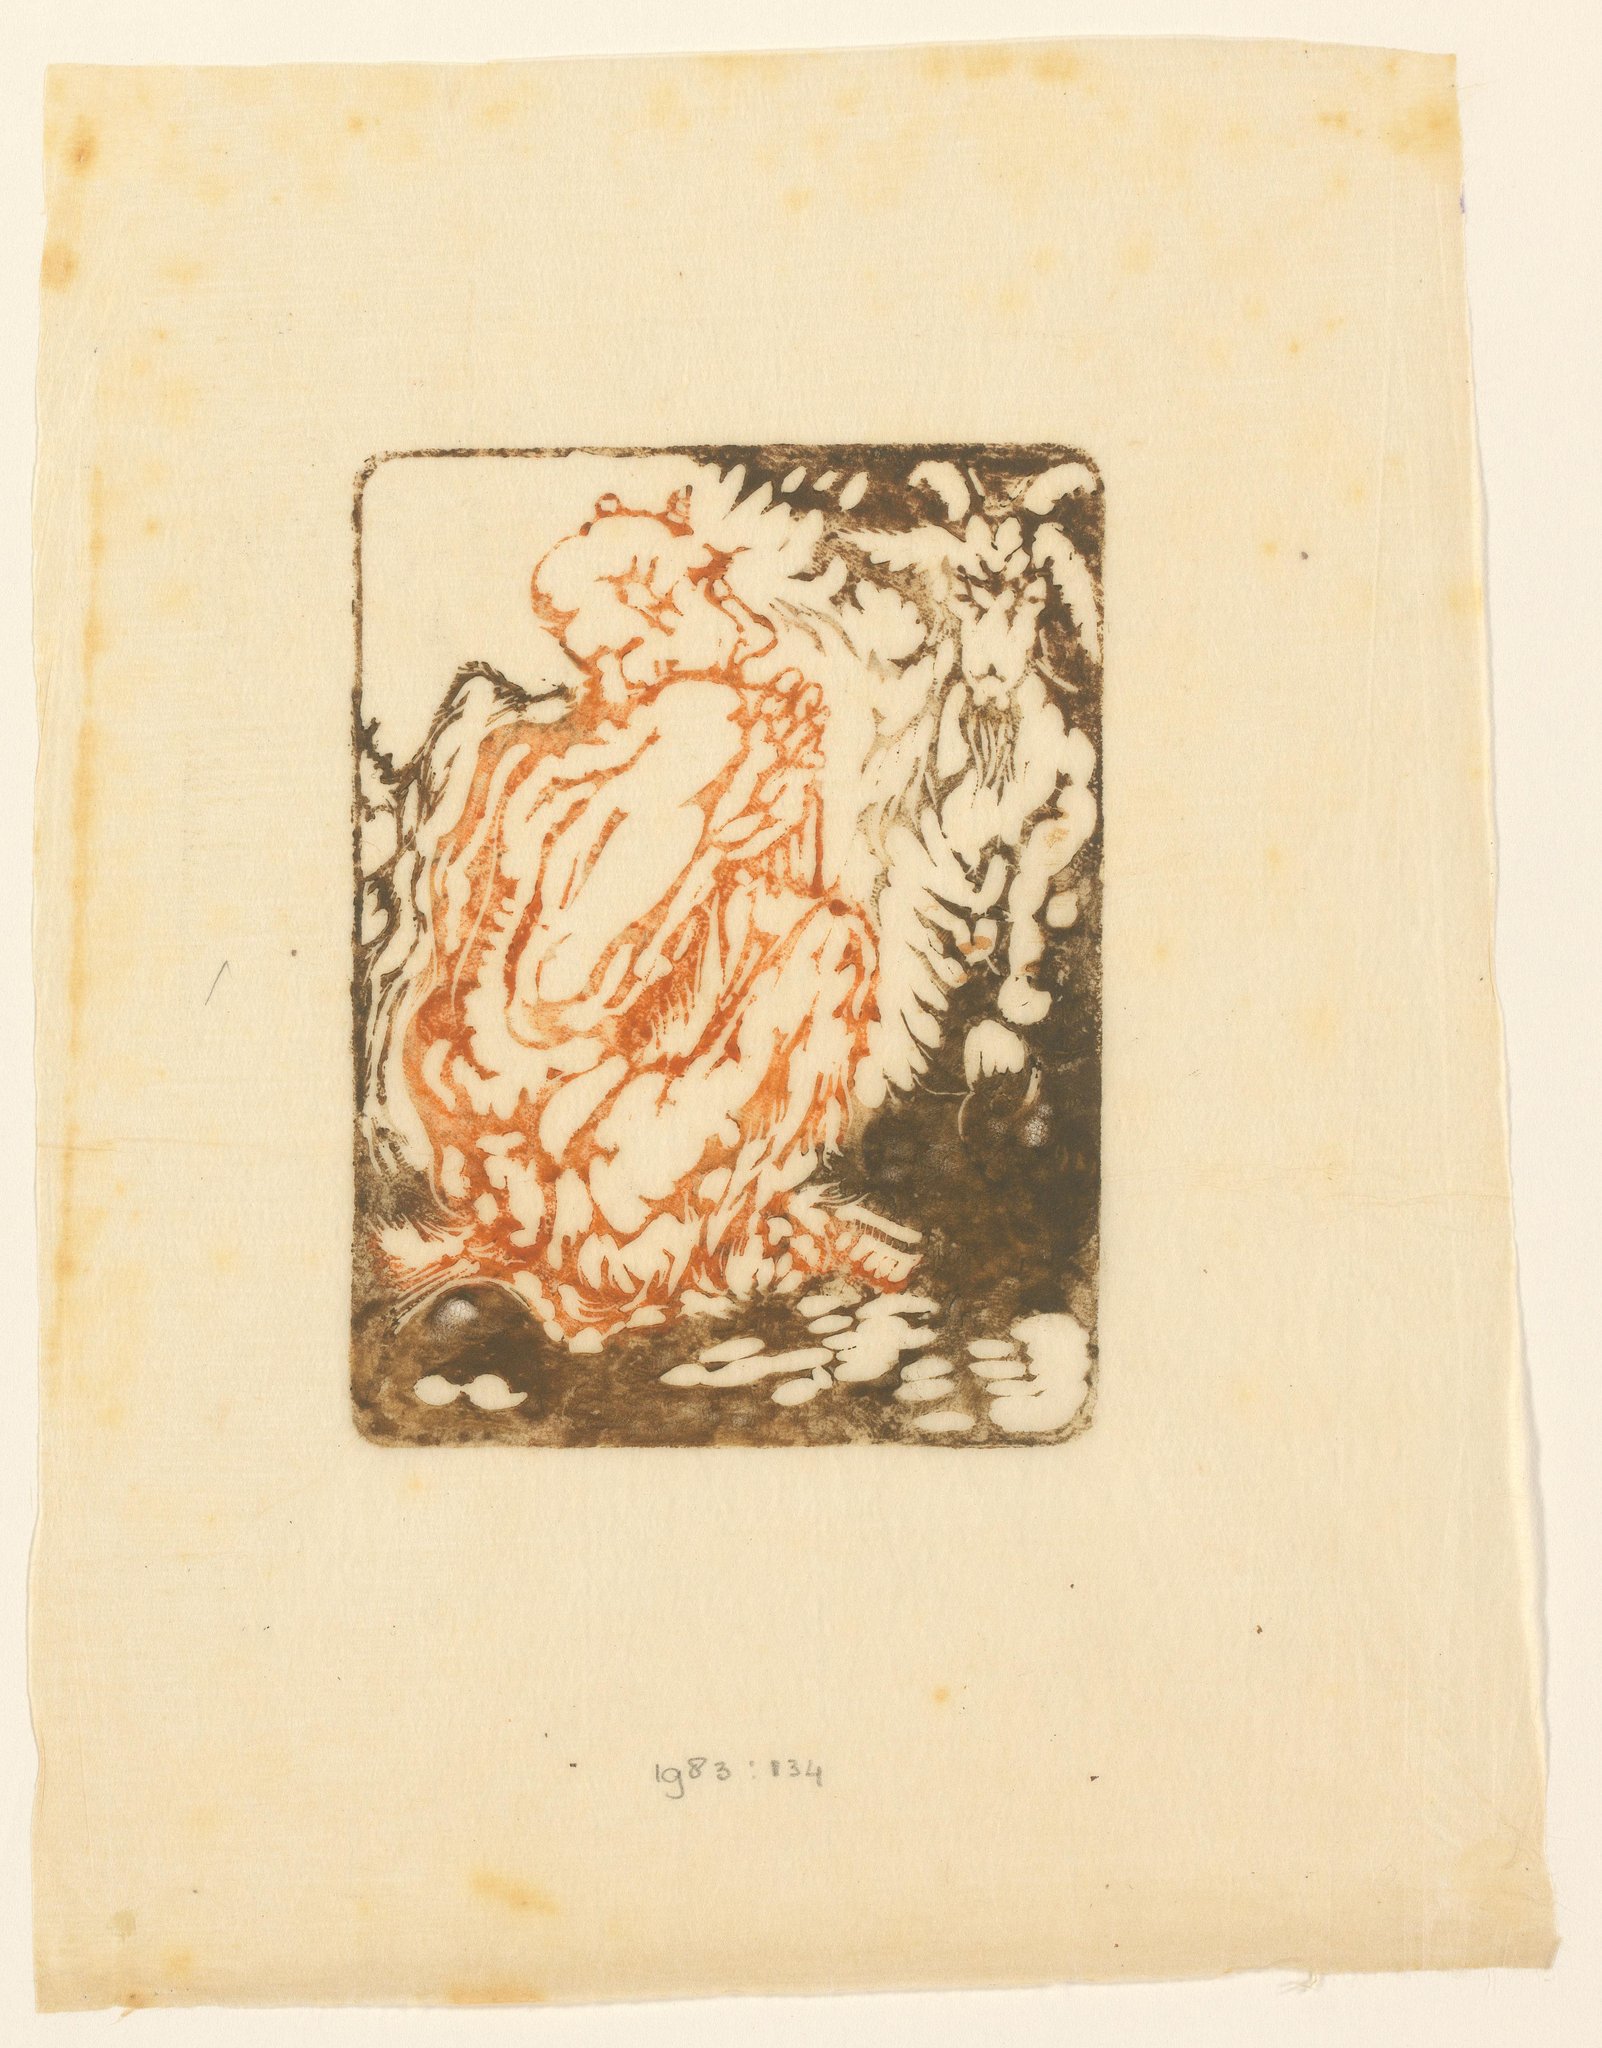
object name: print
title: Faun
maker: otto verhagen (i)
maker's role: draughtsman, print maker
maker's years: 1885-1951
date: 1920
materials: paper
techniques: woodcut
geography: netherlands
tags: satyrs, fauns, sileni, goat